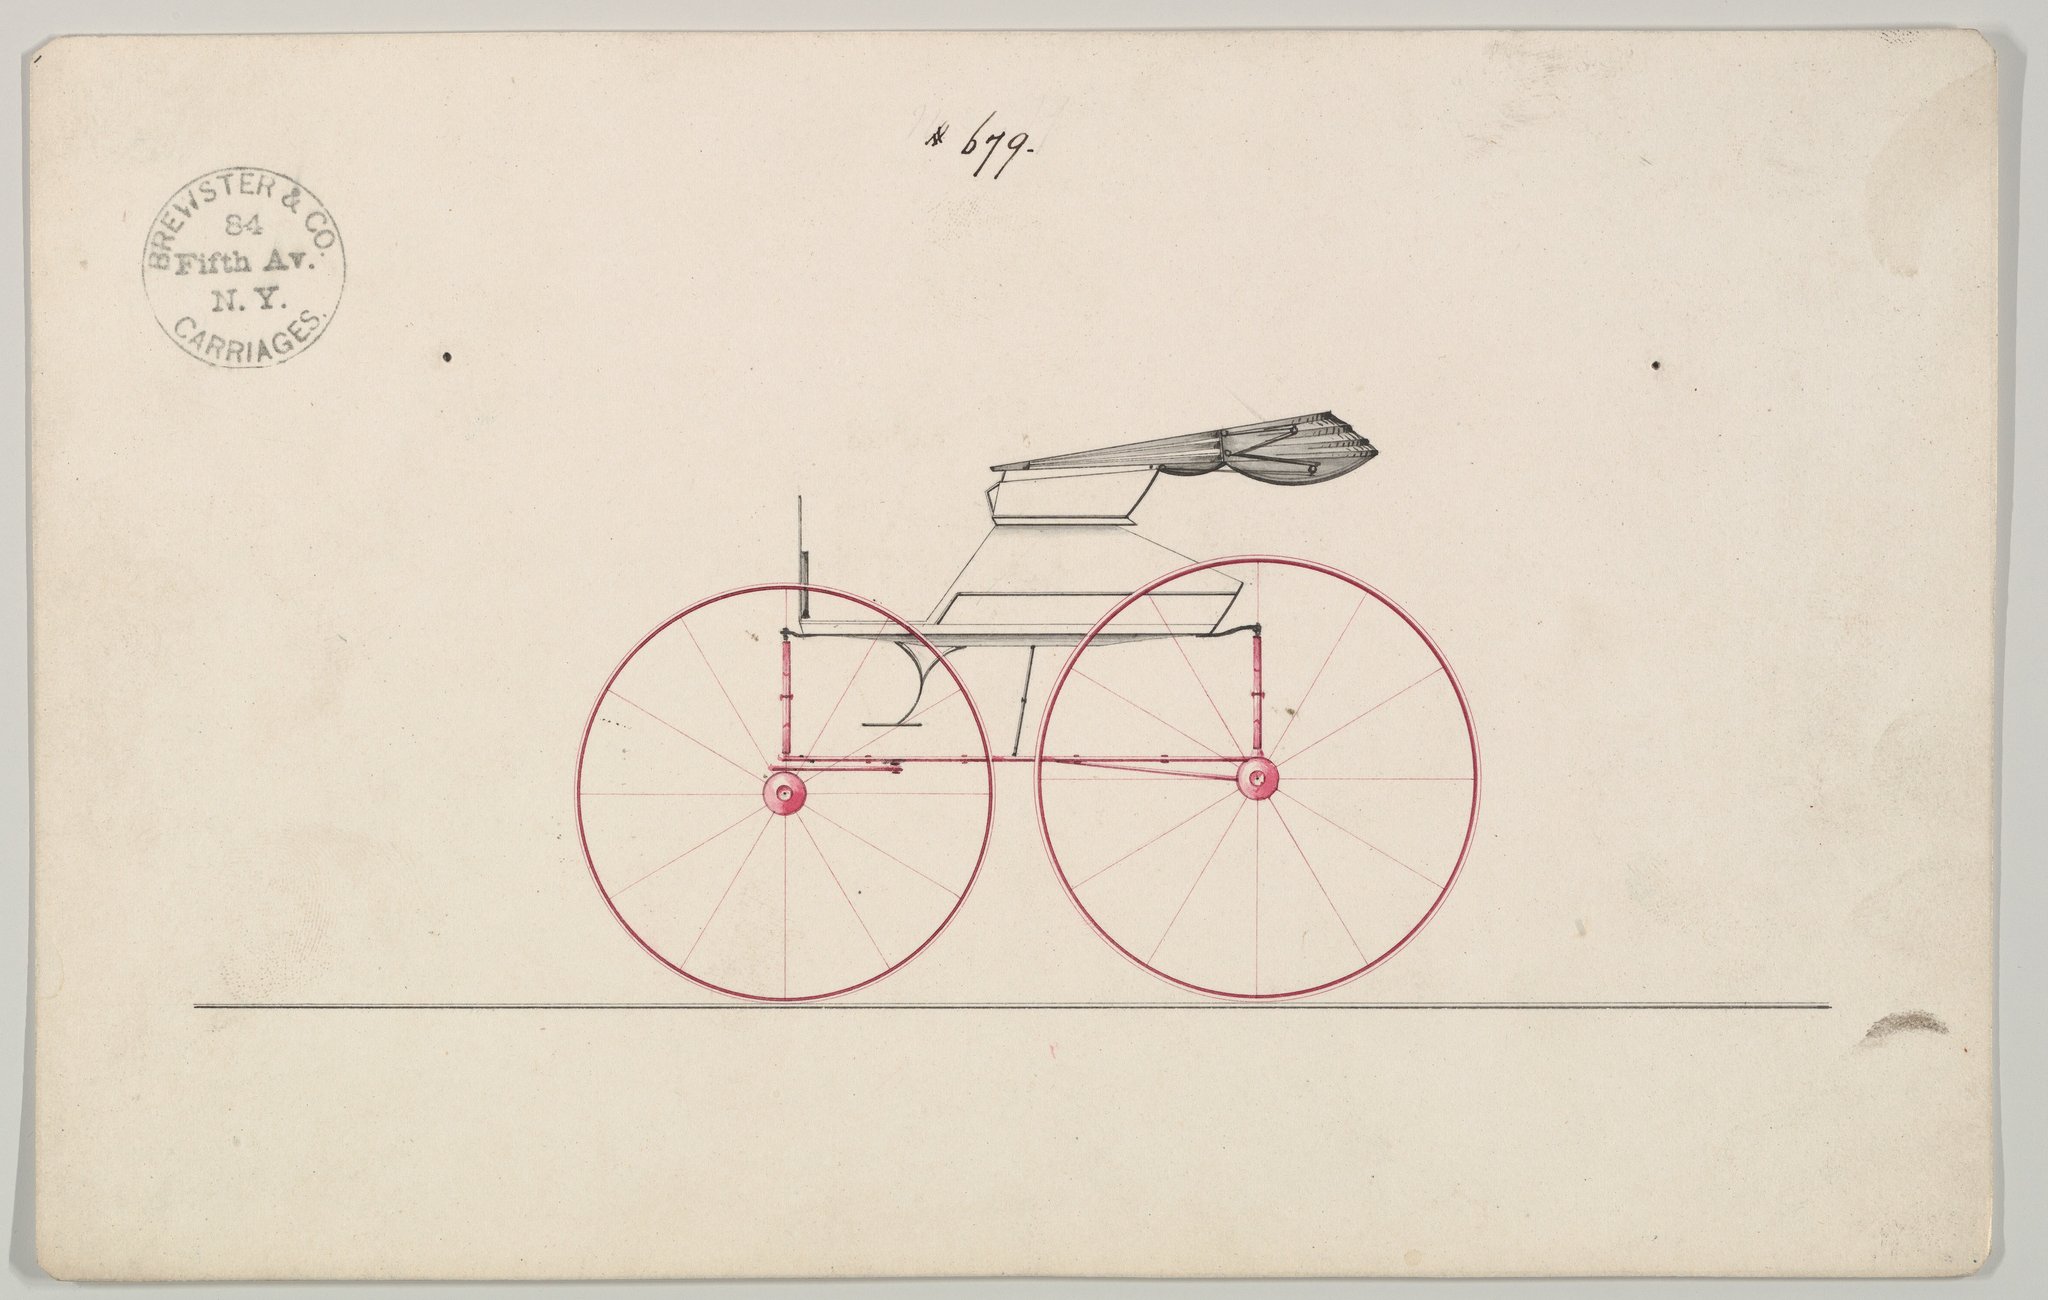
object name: drawing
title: Wagon #679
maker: brewster & co.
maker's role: manufacturer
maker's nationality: american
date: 1865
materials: ink, watercolor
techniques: pen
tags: carriages